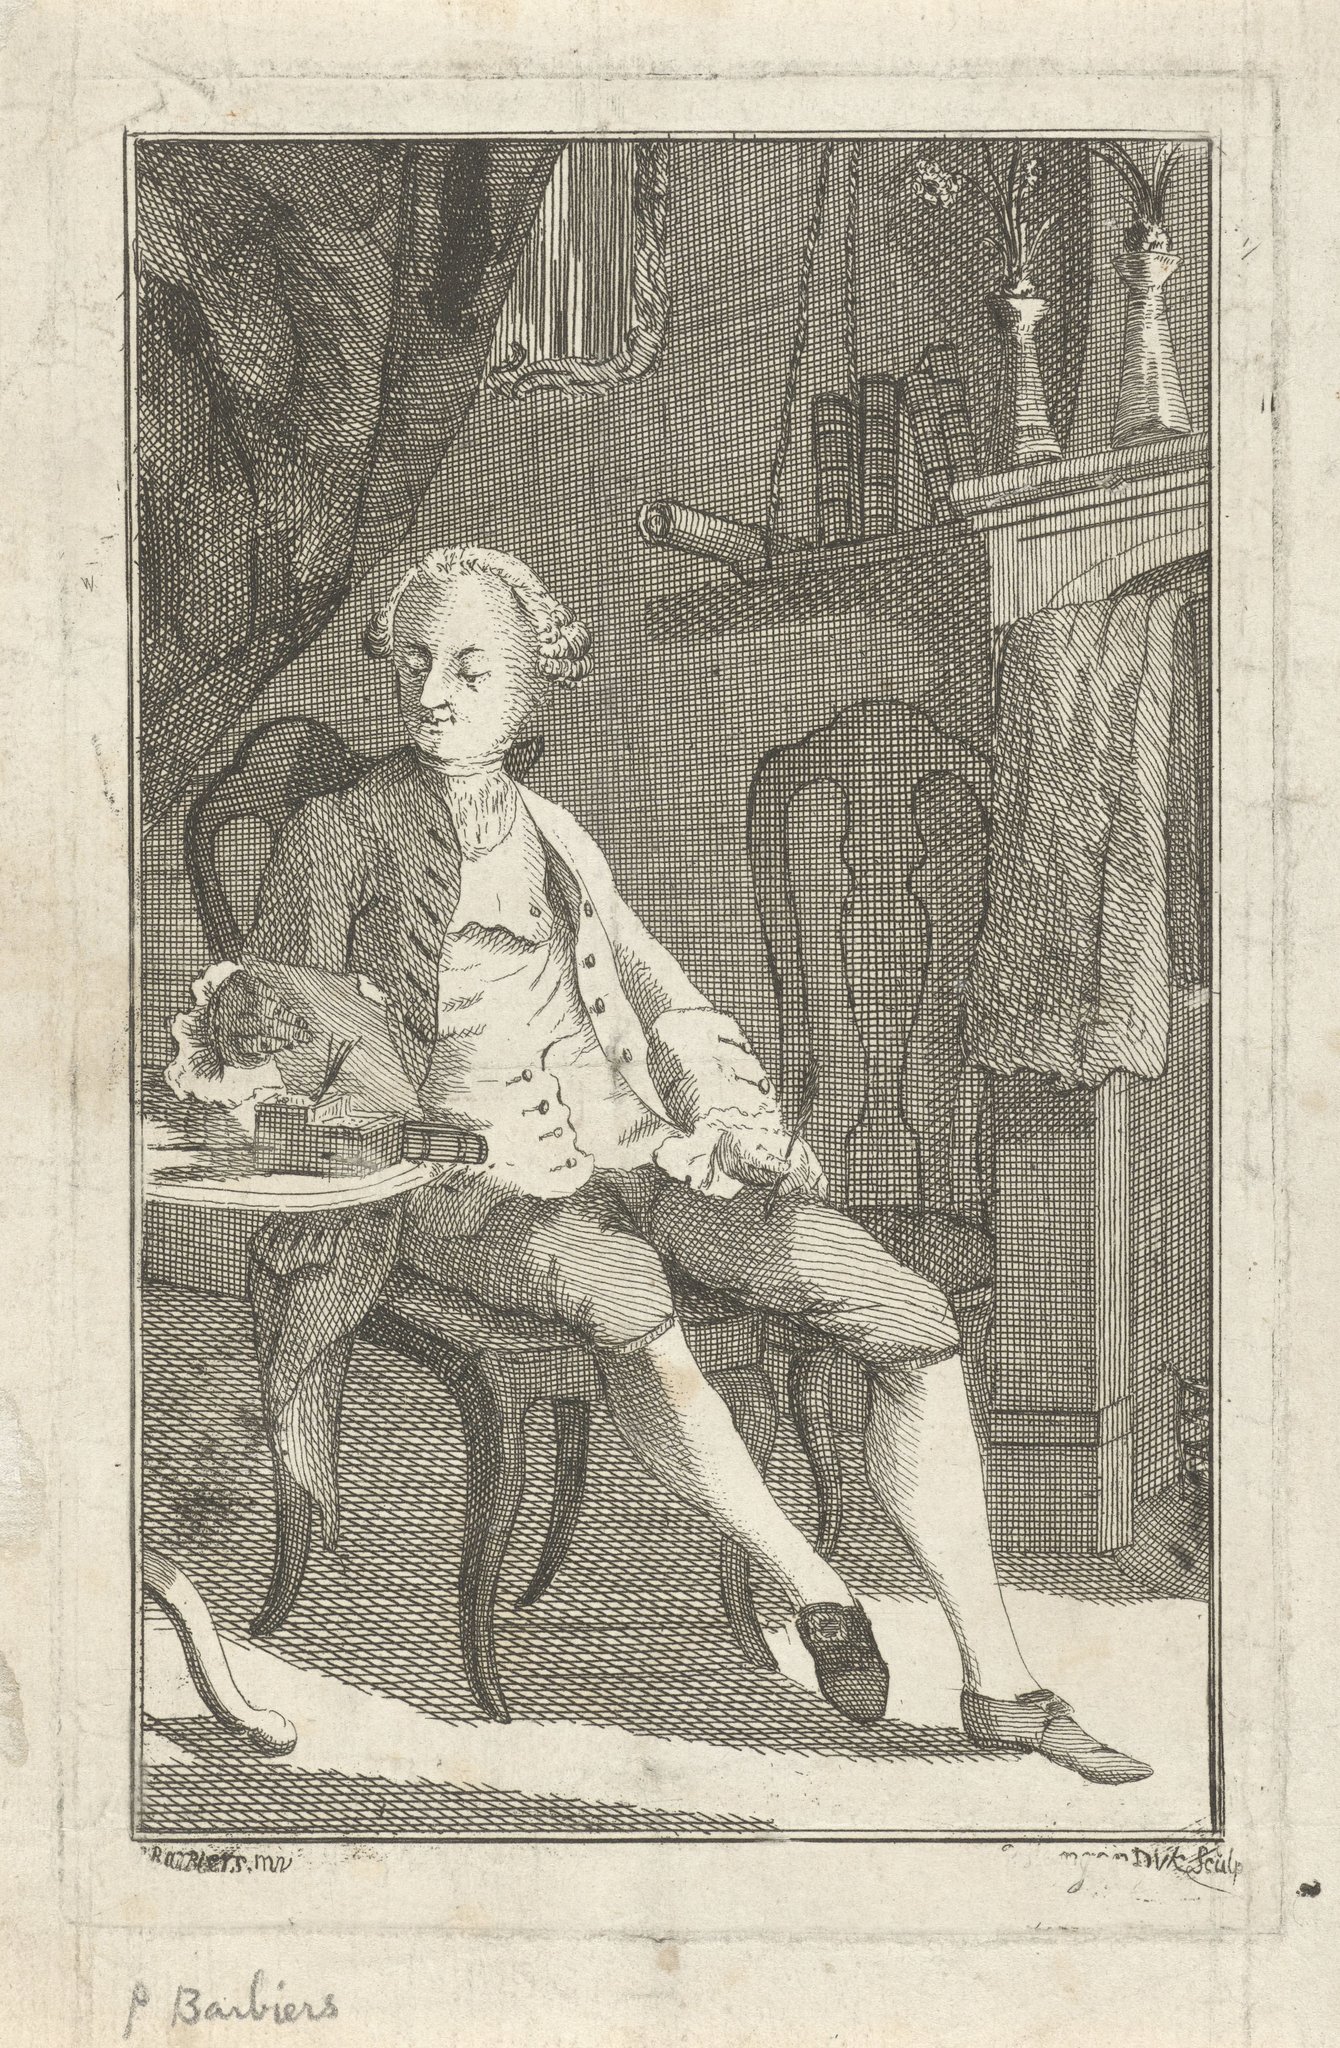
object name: print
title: Heer in een vertrek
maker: pieter barbiers (i)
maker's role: print maker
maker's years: 1717-1780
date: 1727-1780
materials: paper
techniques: etching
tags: interior of the house, letter, envelope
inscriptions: collector's mark: Lugt 2228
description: Een heer zit op een stoel in een vertrek. Hij leest een brief die hij in zijn rechterhand houdt, in de linkerhand houdt hij een pen.